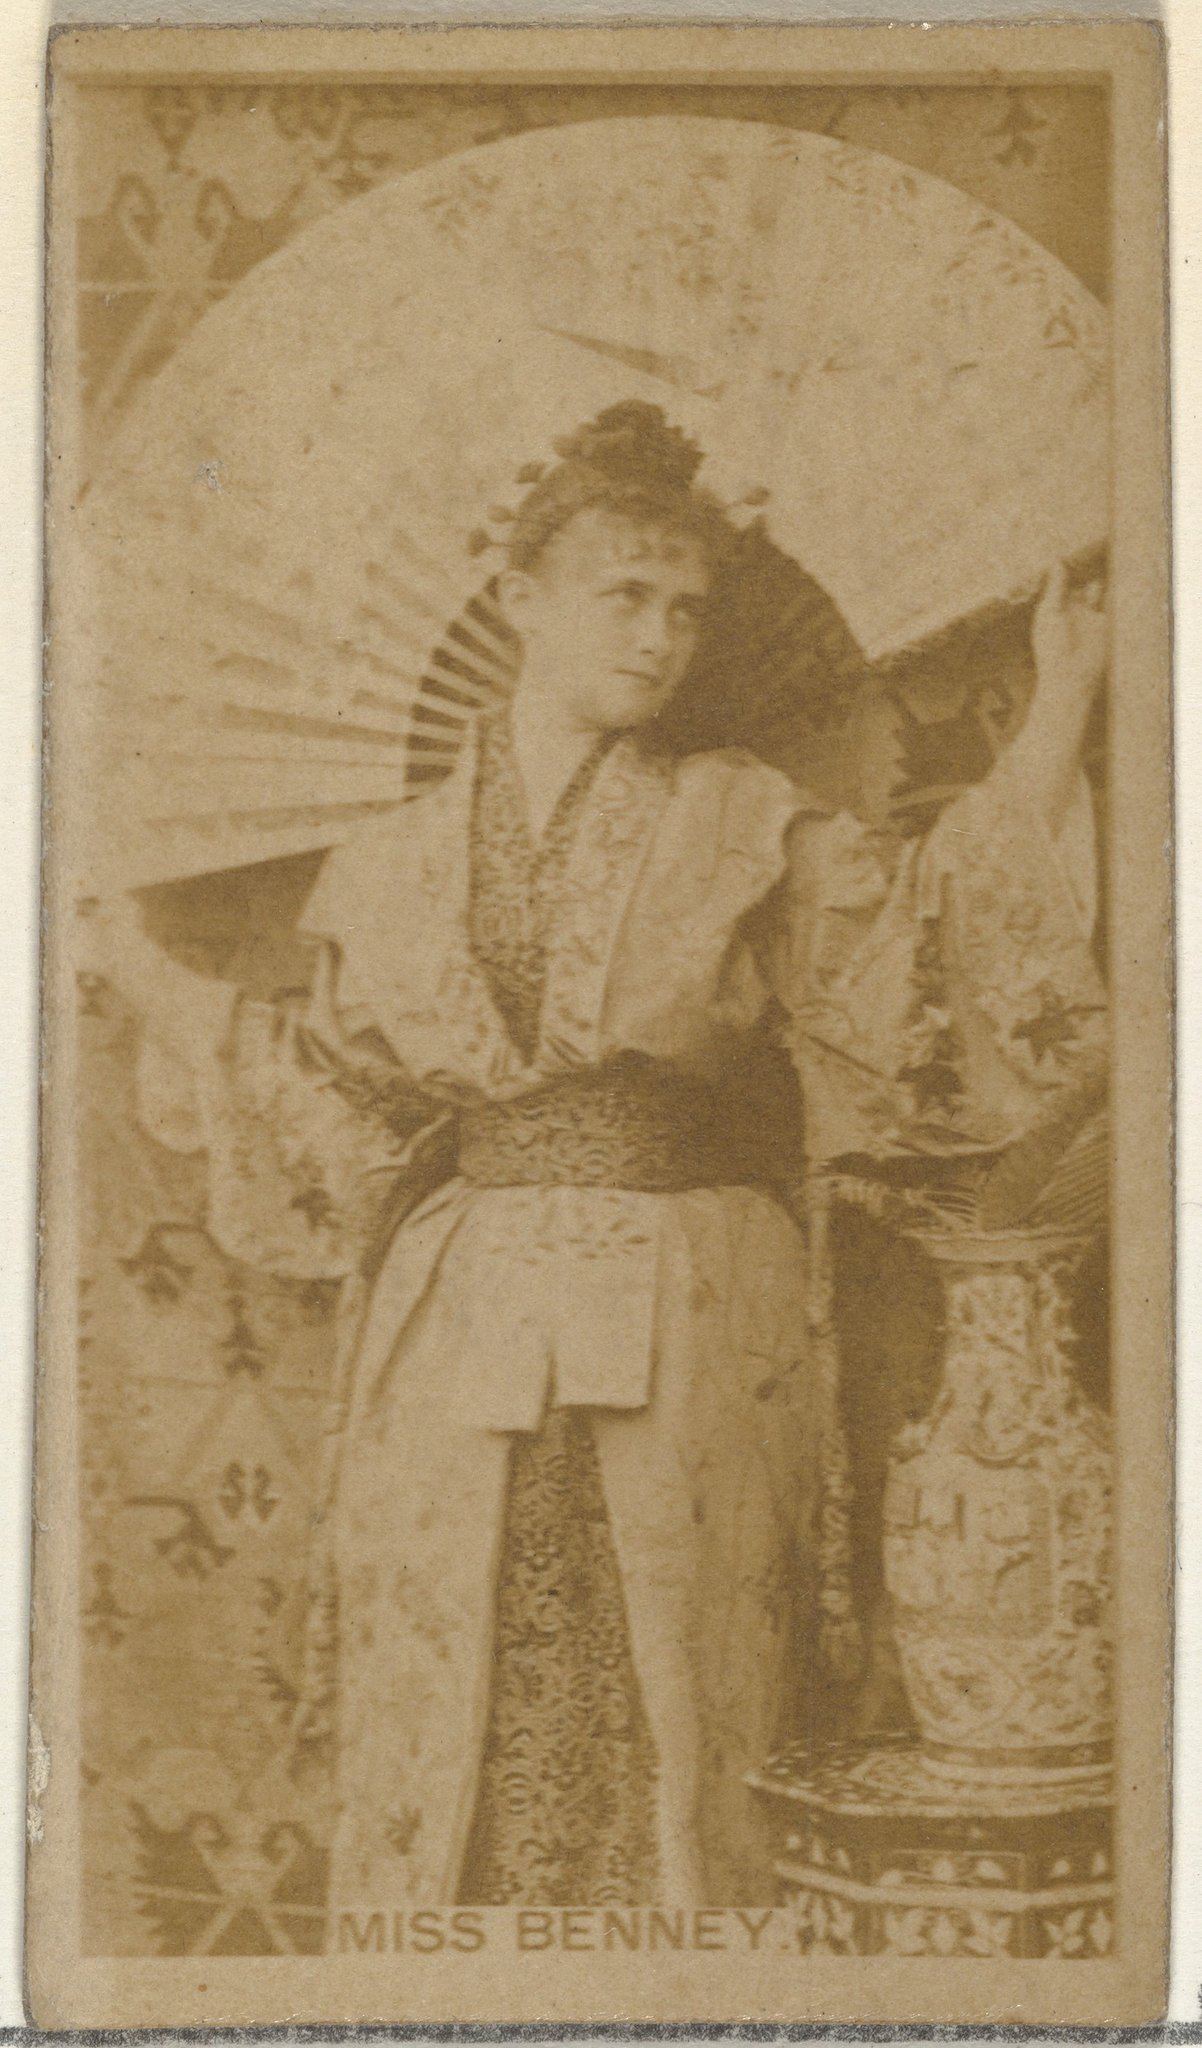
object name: photograph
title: Miss Benney, from the Actors and Actresses series (N145-8) issued by Duke Sons & Co. to promote Duke Cigarettes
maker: w. duke, sons & co.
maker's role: publisher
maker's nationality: american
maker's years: 1870-1920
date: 1891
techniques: albumen silver print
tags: portraits,women,actresses